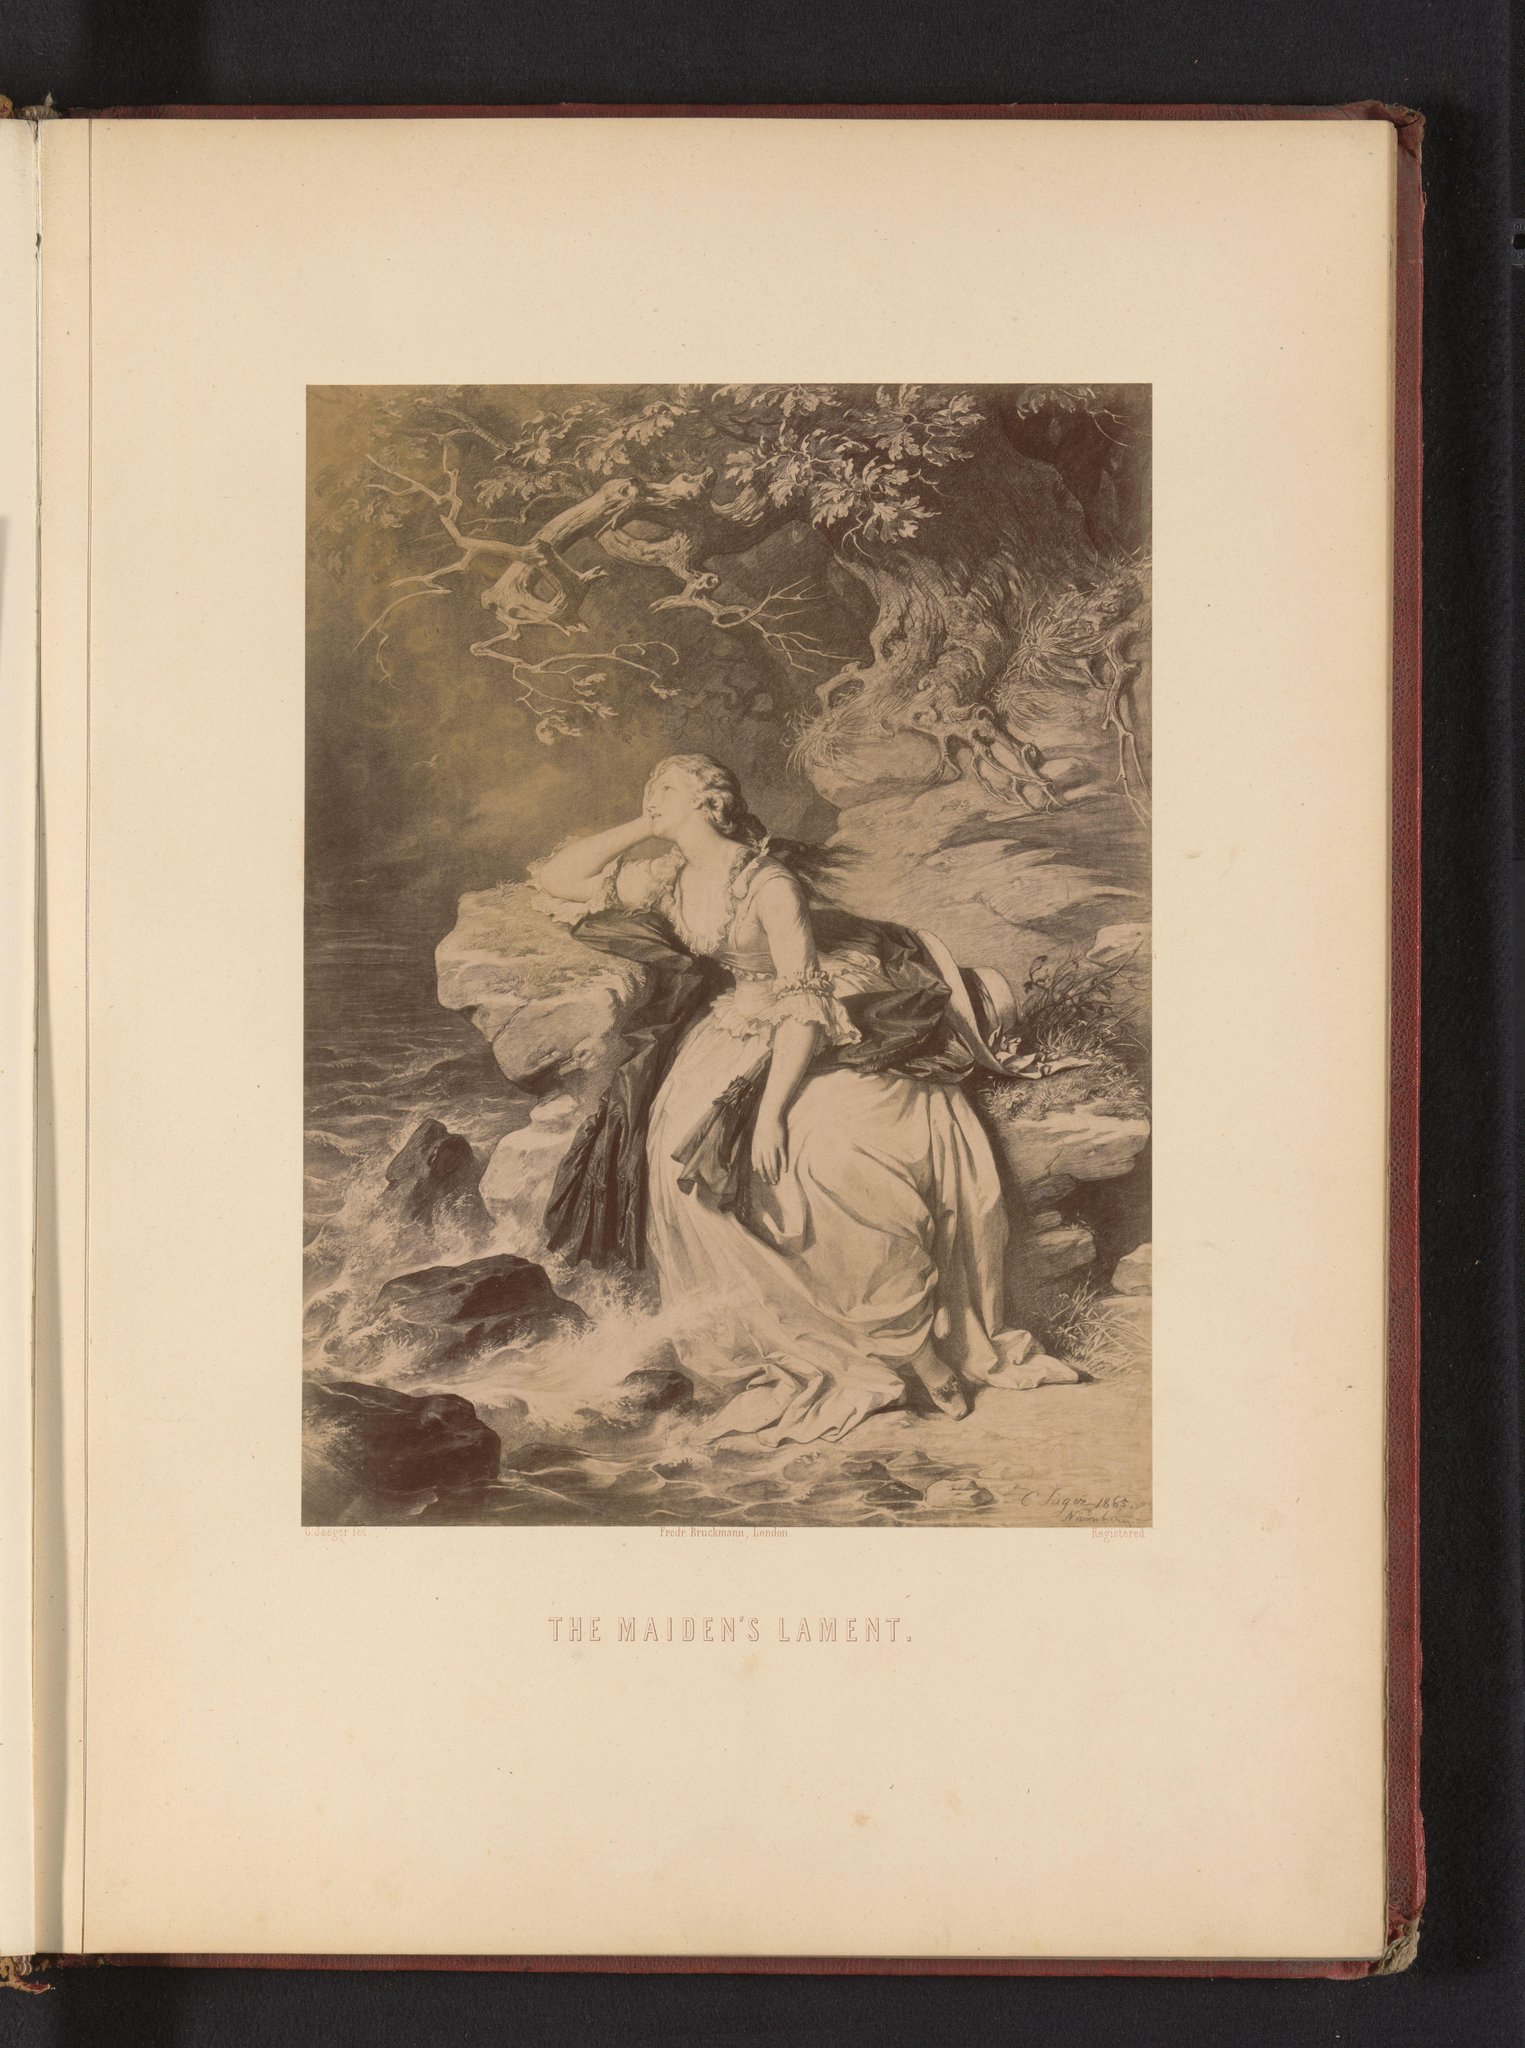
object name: page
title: Fotoreproductie van een tekening van een scene uit een toneelstuk van Friedrich Schiller met een treurende dame, door Carl Jaeger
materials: photographic support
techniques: albumen print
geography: london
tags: weeping (+ sideview, profile)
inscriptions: inscription: ‘Registered.’